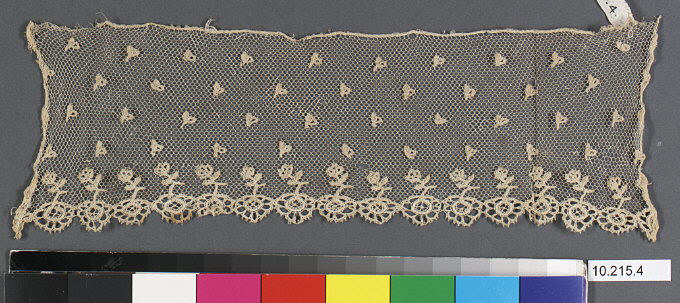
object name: piece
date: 1801-1900